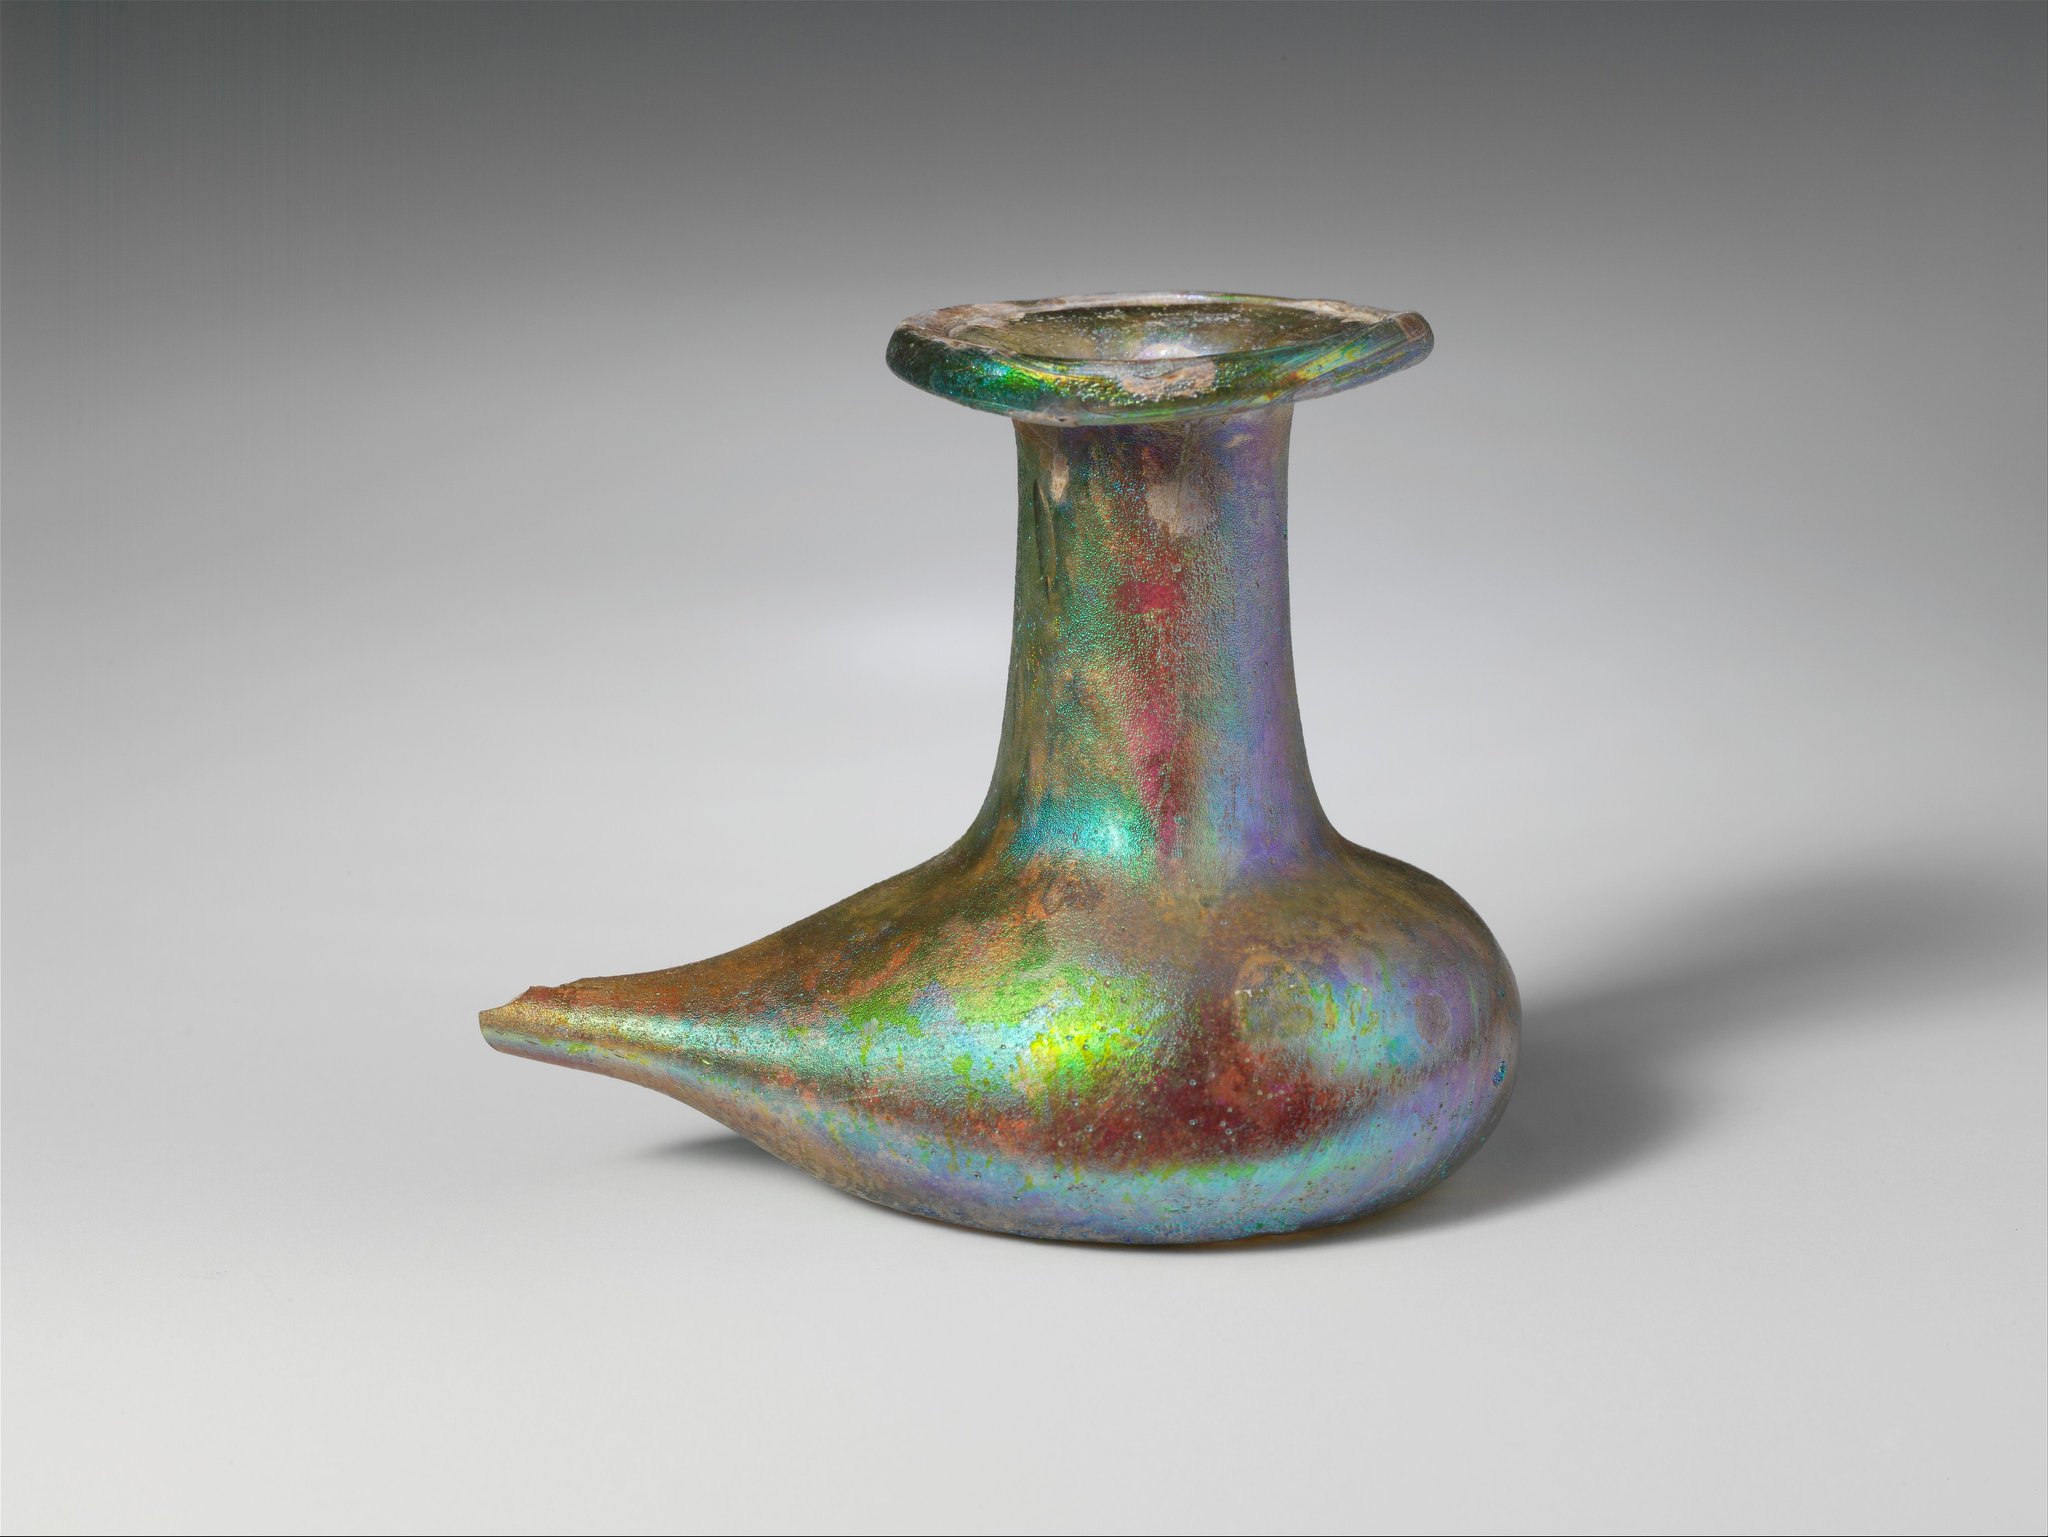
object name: pourer flask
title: Glass pourer flask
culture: roman, cypriot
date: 101-233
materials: glass